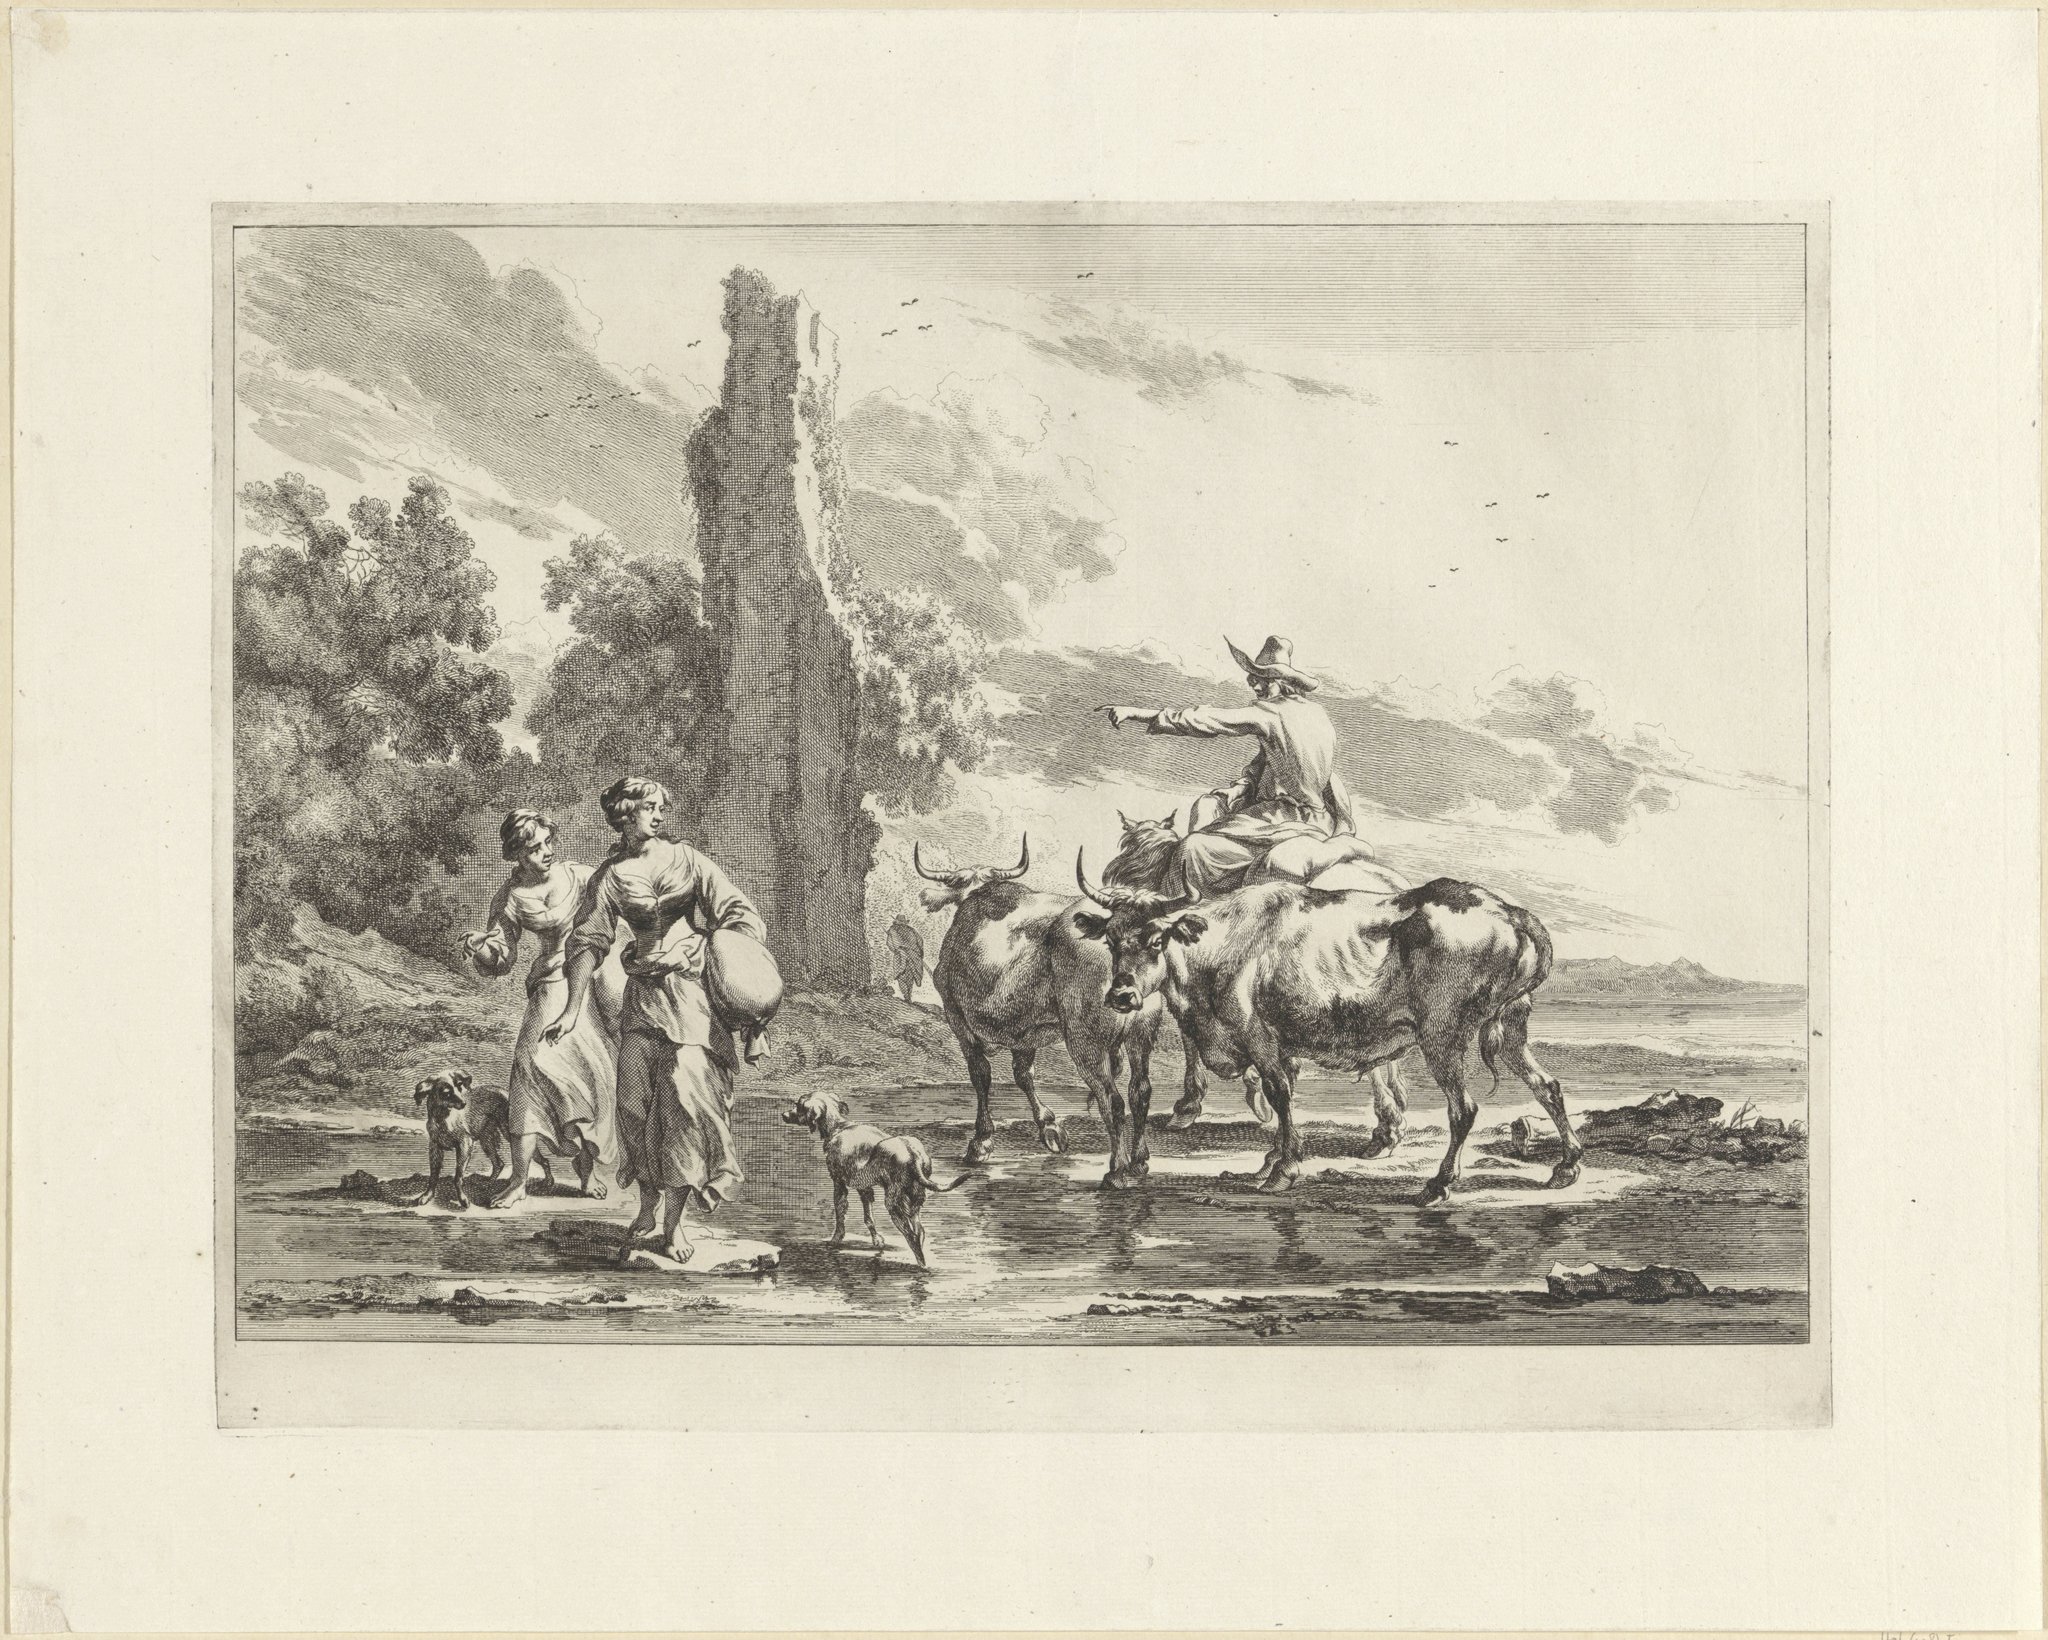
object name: print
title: Herder en herderinnen in een voorde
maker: jan de visscher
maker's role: print maker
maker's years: 1633-1712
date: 1643-1692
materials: paper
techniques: engraving, etching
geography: northern netherlands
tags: cow, herding, herdsman, herdswoman, shepherd, shepherdess, cowherd, etc., ford, index finger forwards, pointing, indicating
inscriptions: collector's mark: Lugt 240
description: In een voorde wijst een herder te paard twee herderinnen met honden iets aan. De herder heeft twee koeien bij zich.